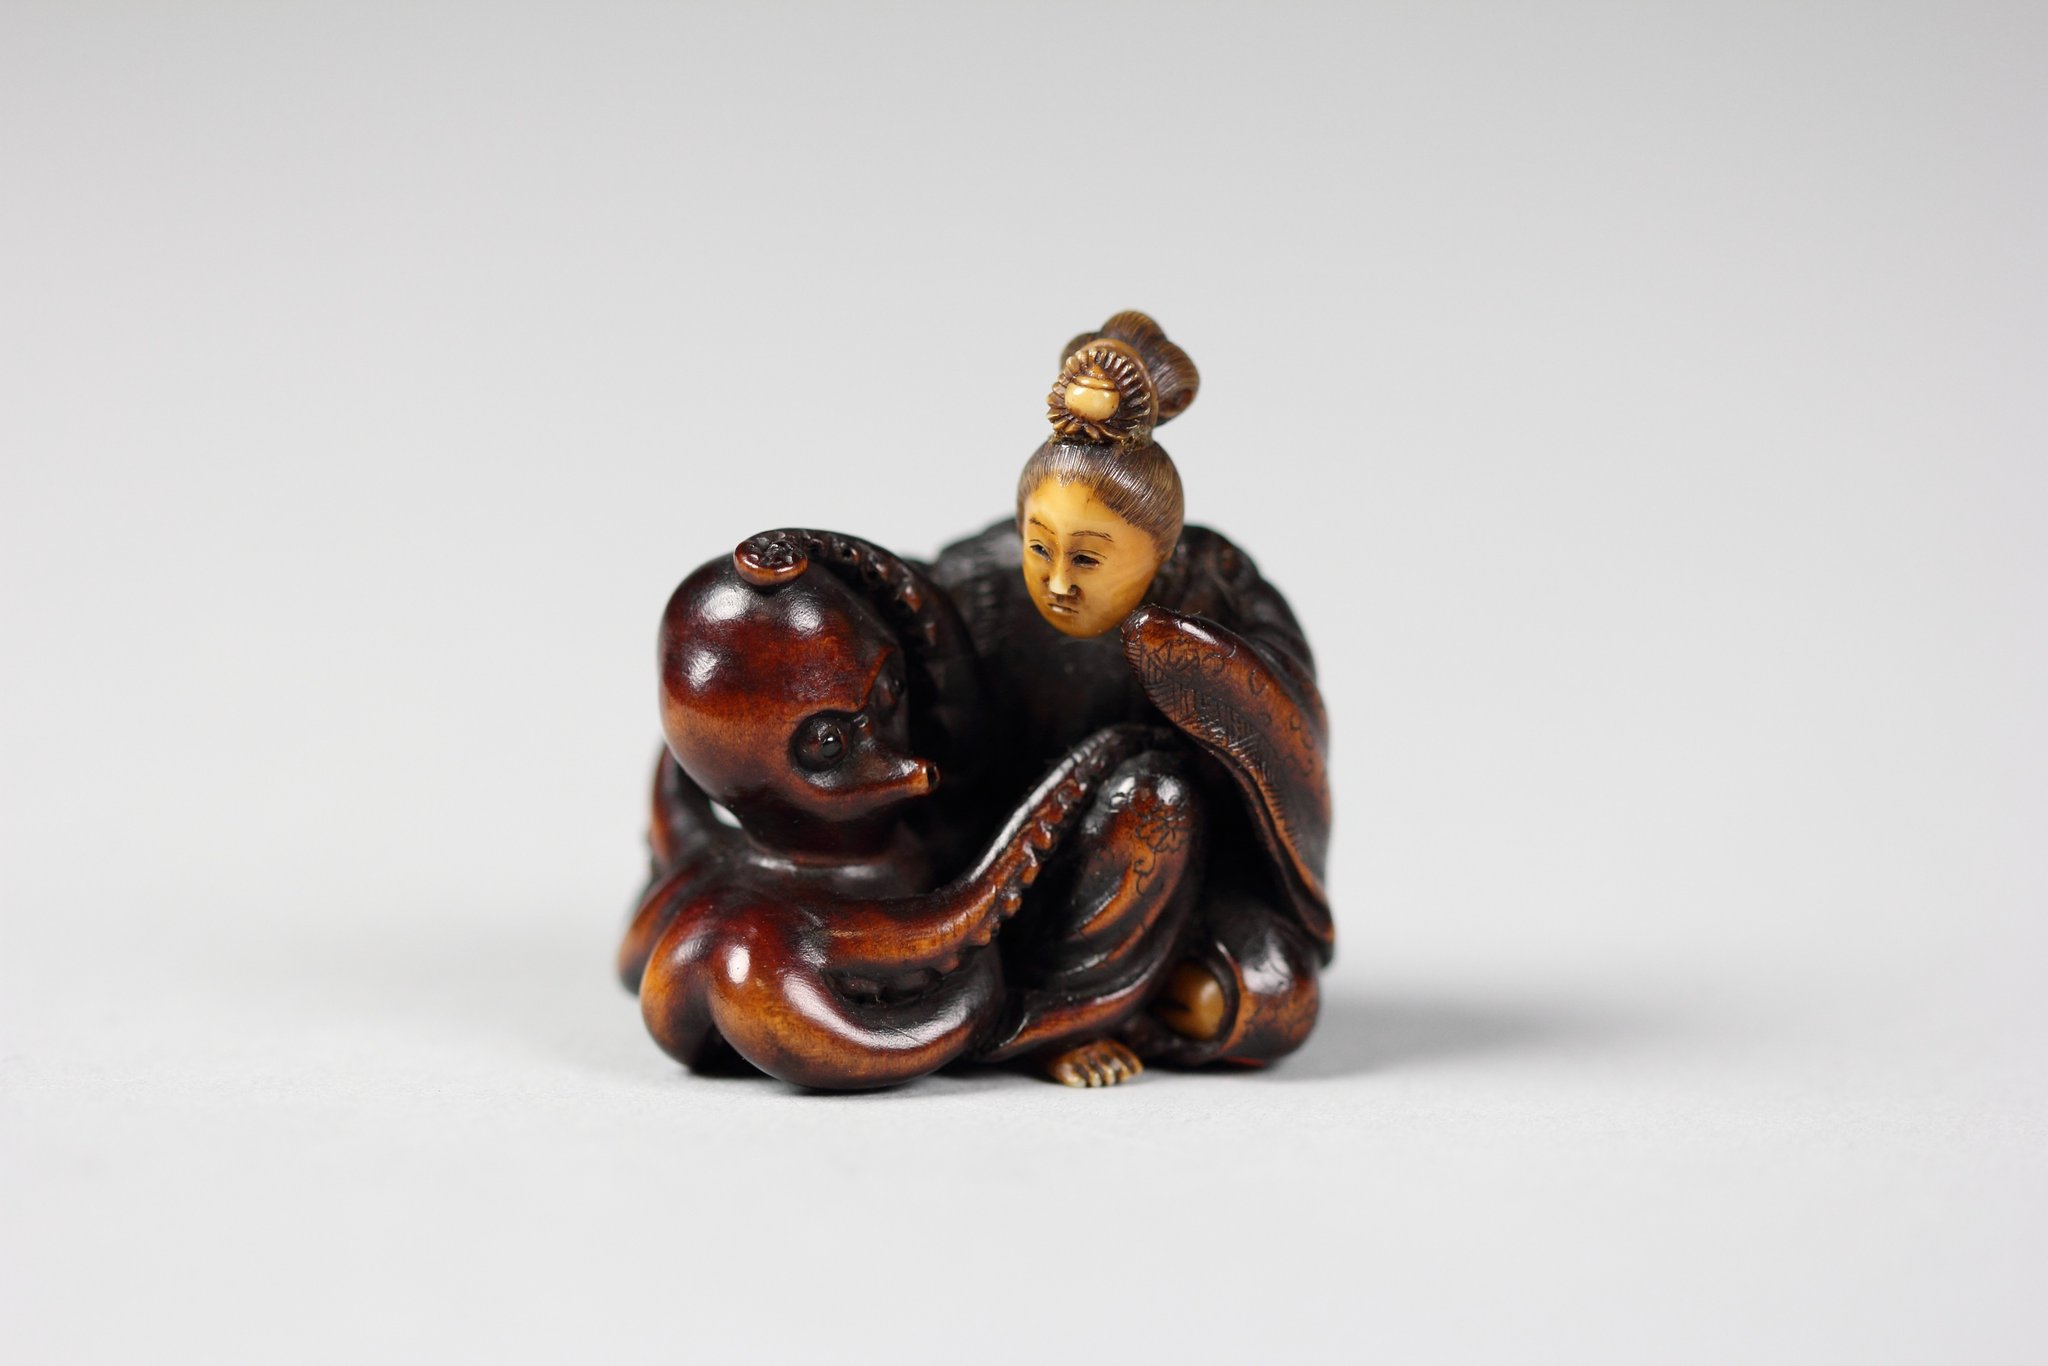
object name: netsuke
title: Netsuke of Octopus and Woman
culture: japanese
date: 1801-1900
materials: wood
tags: women,octopus